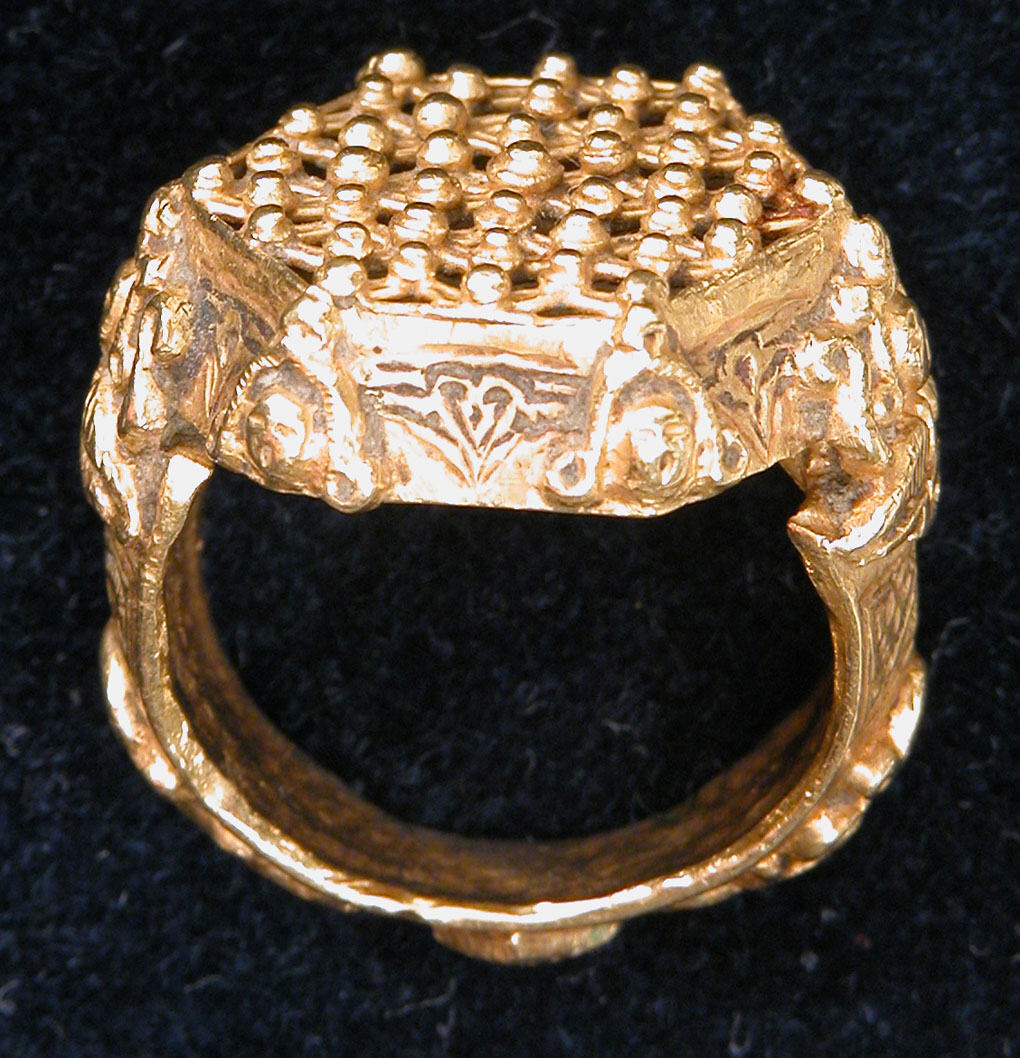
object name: ring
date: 1101-1300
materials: gold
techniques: casting, engraving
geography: iran